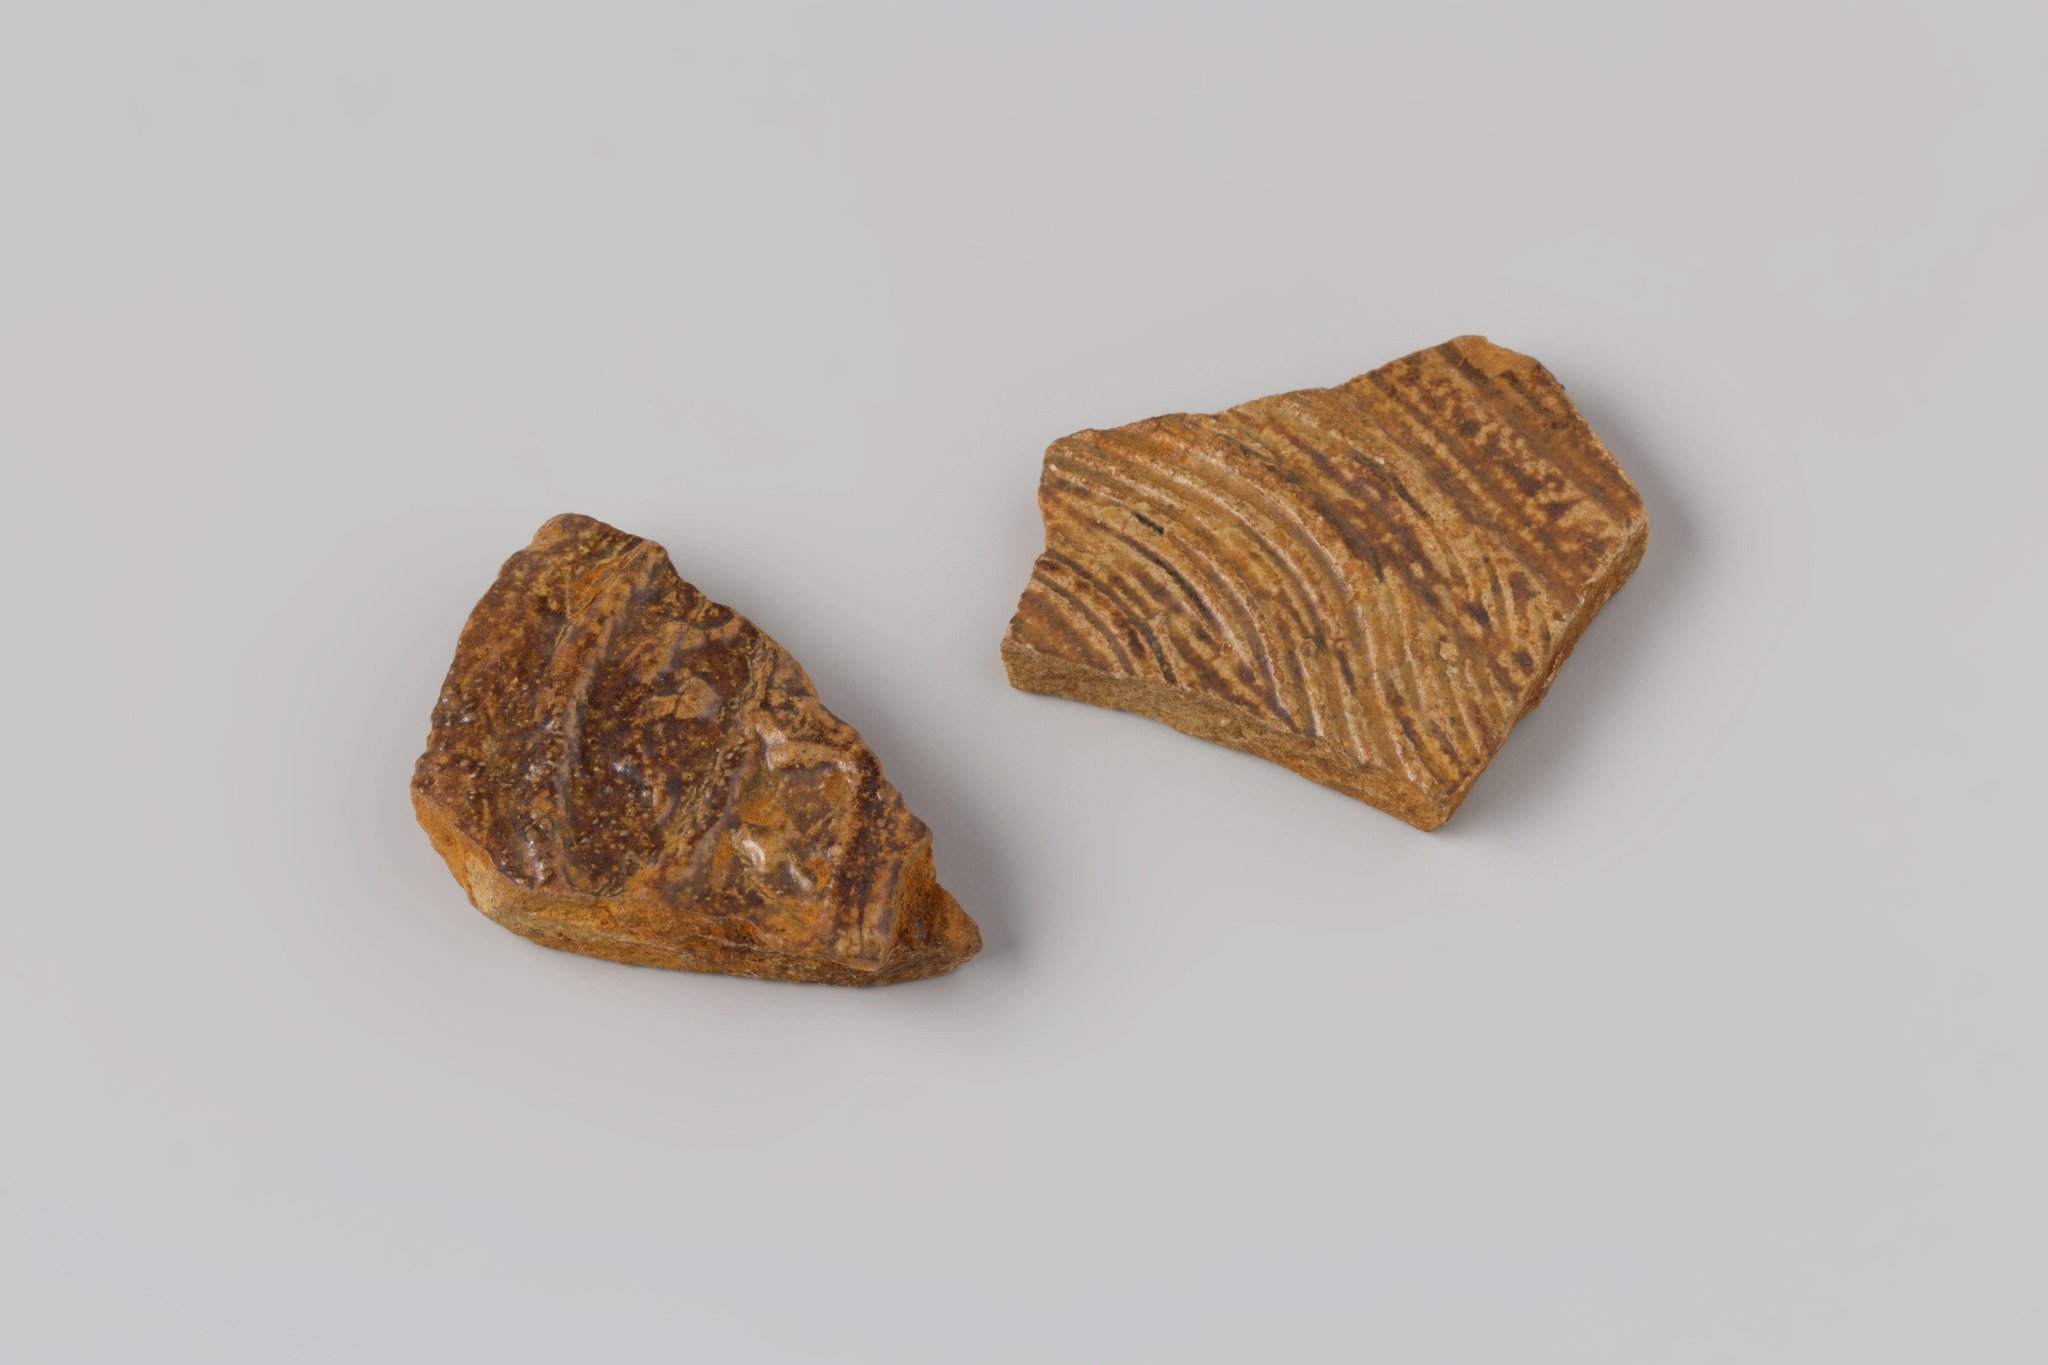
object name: sherd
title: Scherven van voorraadpotten uit het wrak van de Oost-Indiëvaarder Hollandia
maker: Anonymous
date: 1700-1743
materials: stoneware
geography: cologne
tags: verenigde oostindische compagnie, hollandia (schip), annet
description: Stoneware, Rhenish, Langerwehe-ware, storage-jar; fragm of body with medallion-appliqué and wavy and reeded pattern sim. NG 1980-27H409/909.